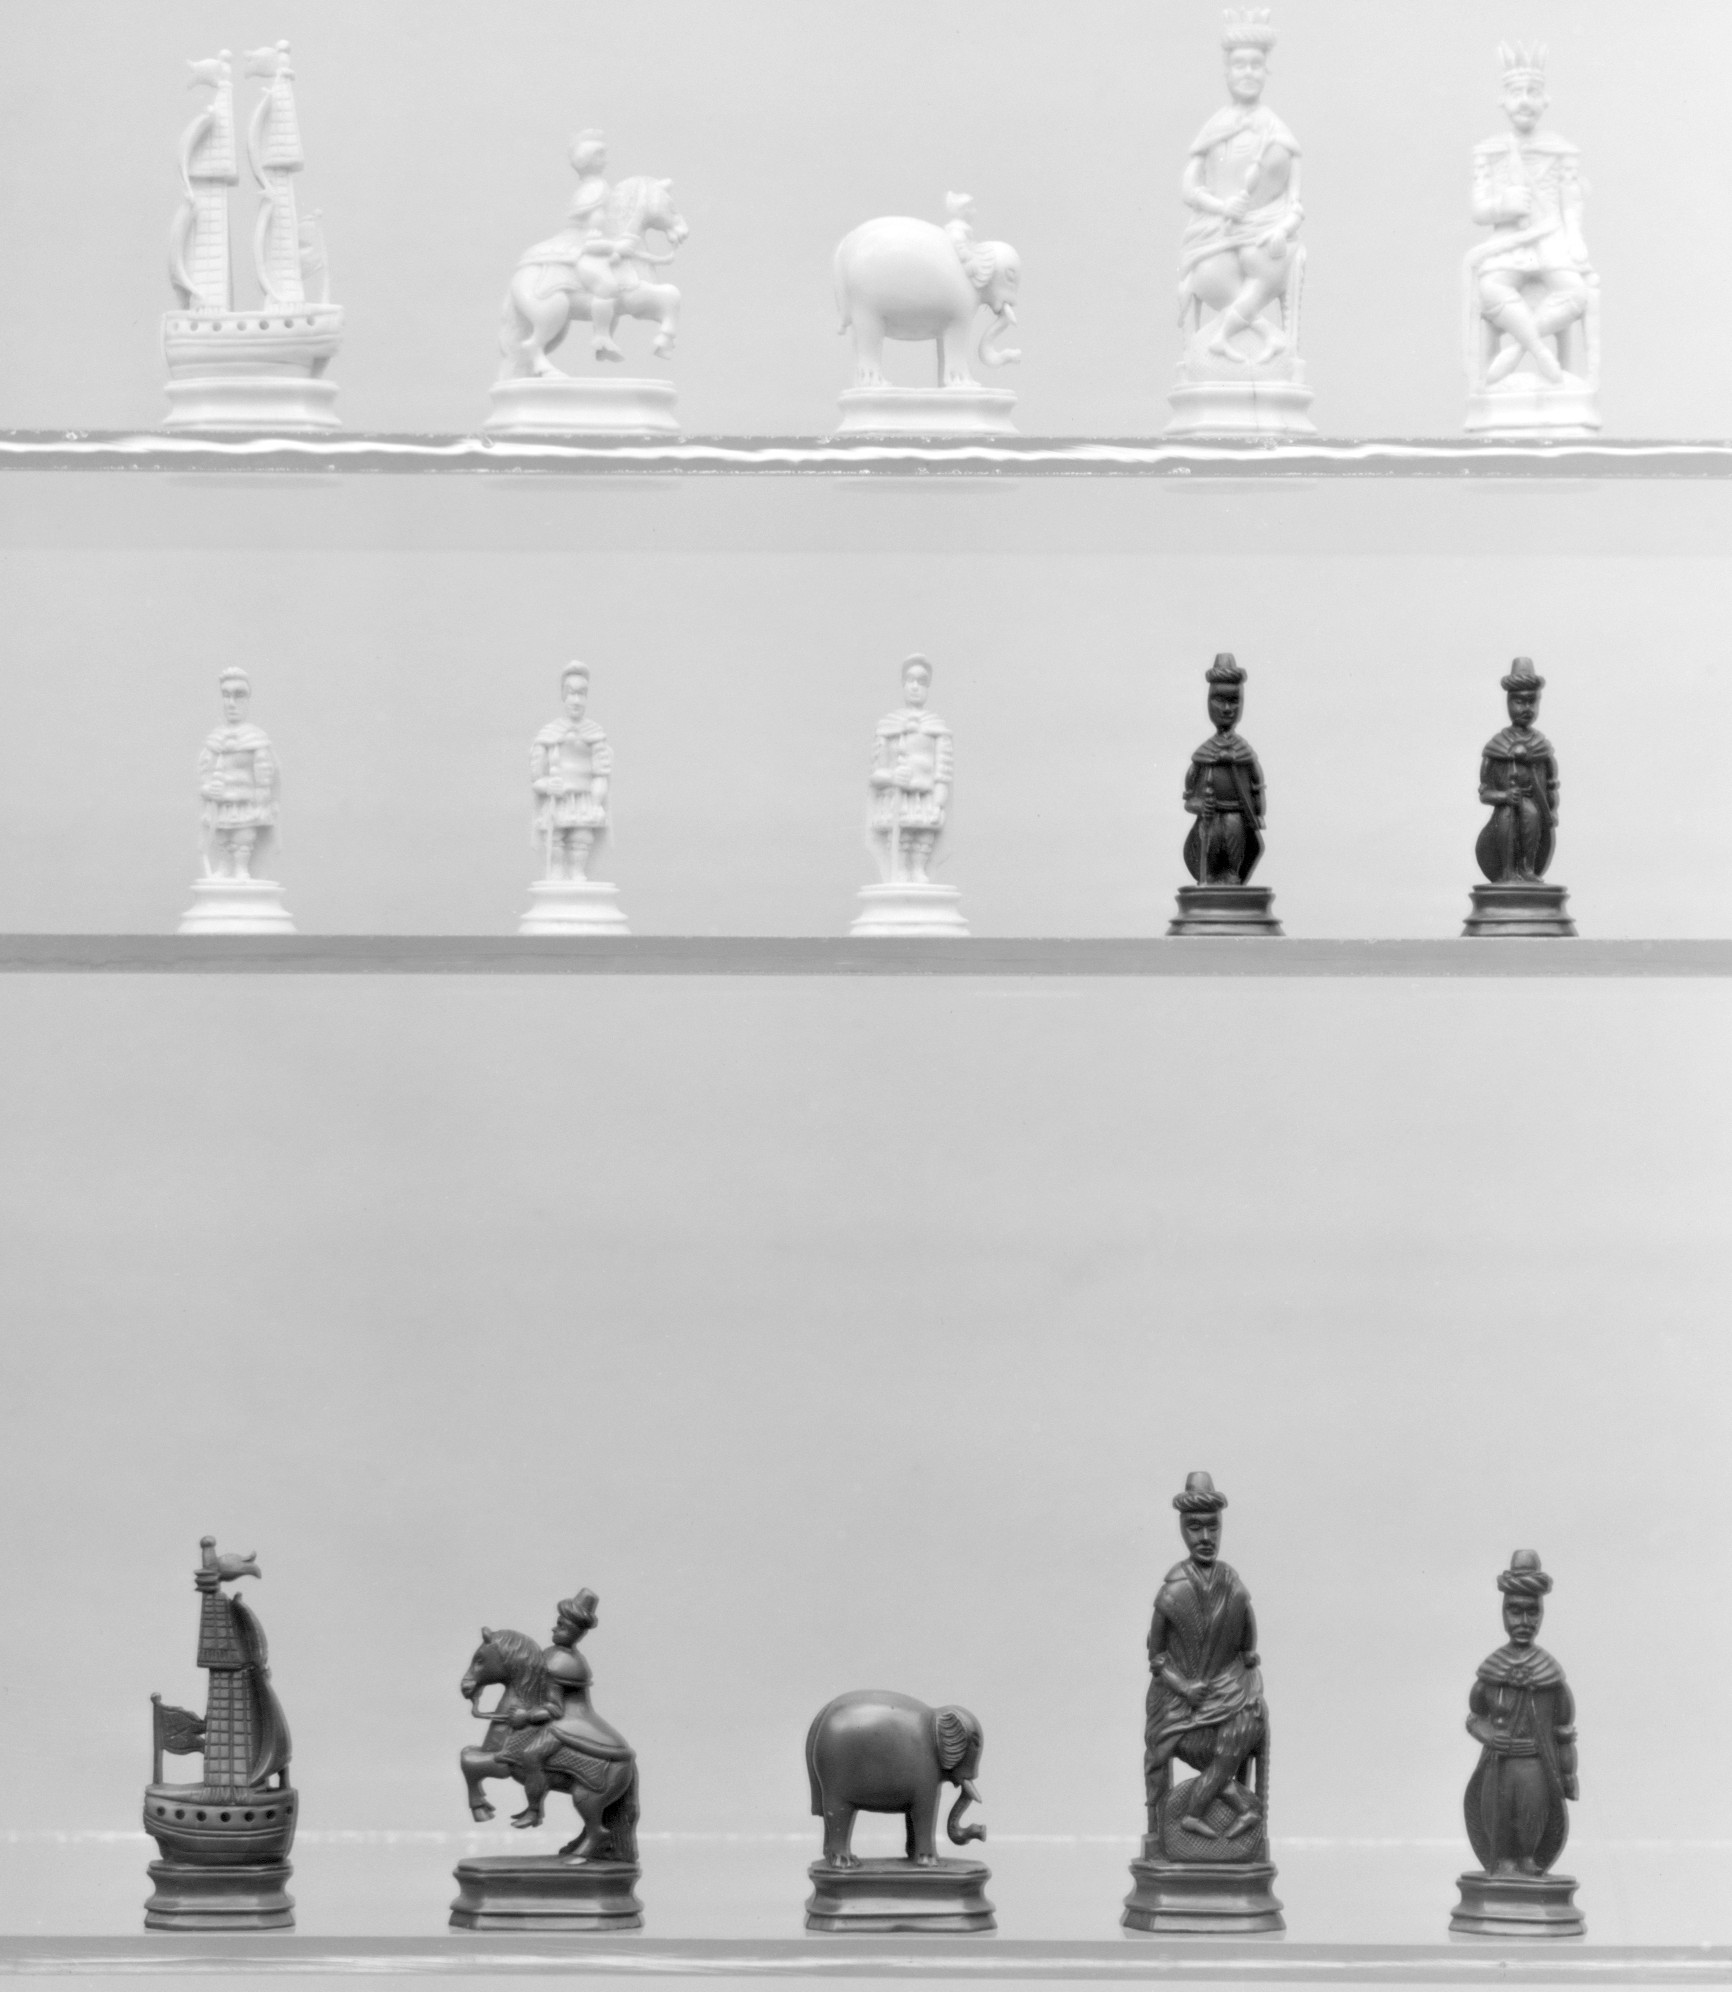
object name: chessman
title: Chessmen (32)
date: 1701-1900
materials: ivory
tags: chess,games